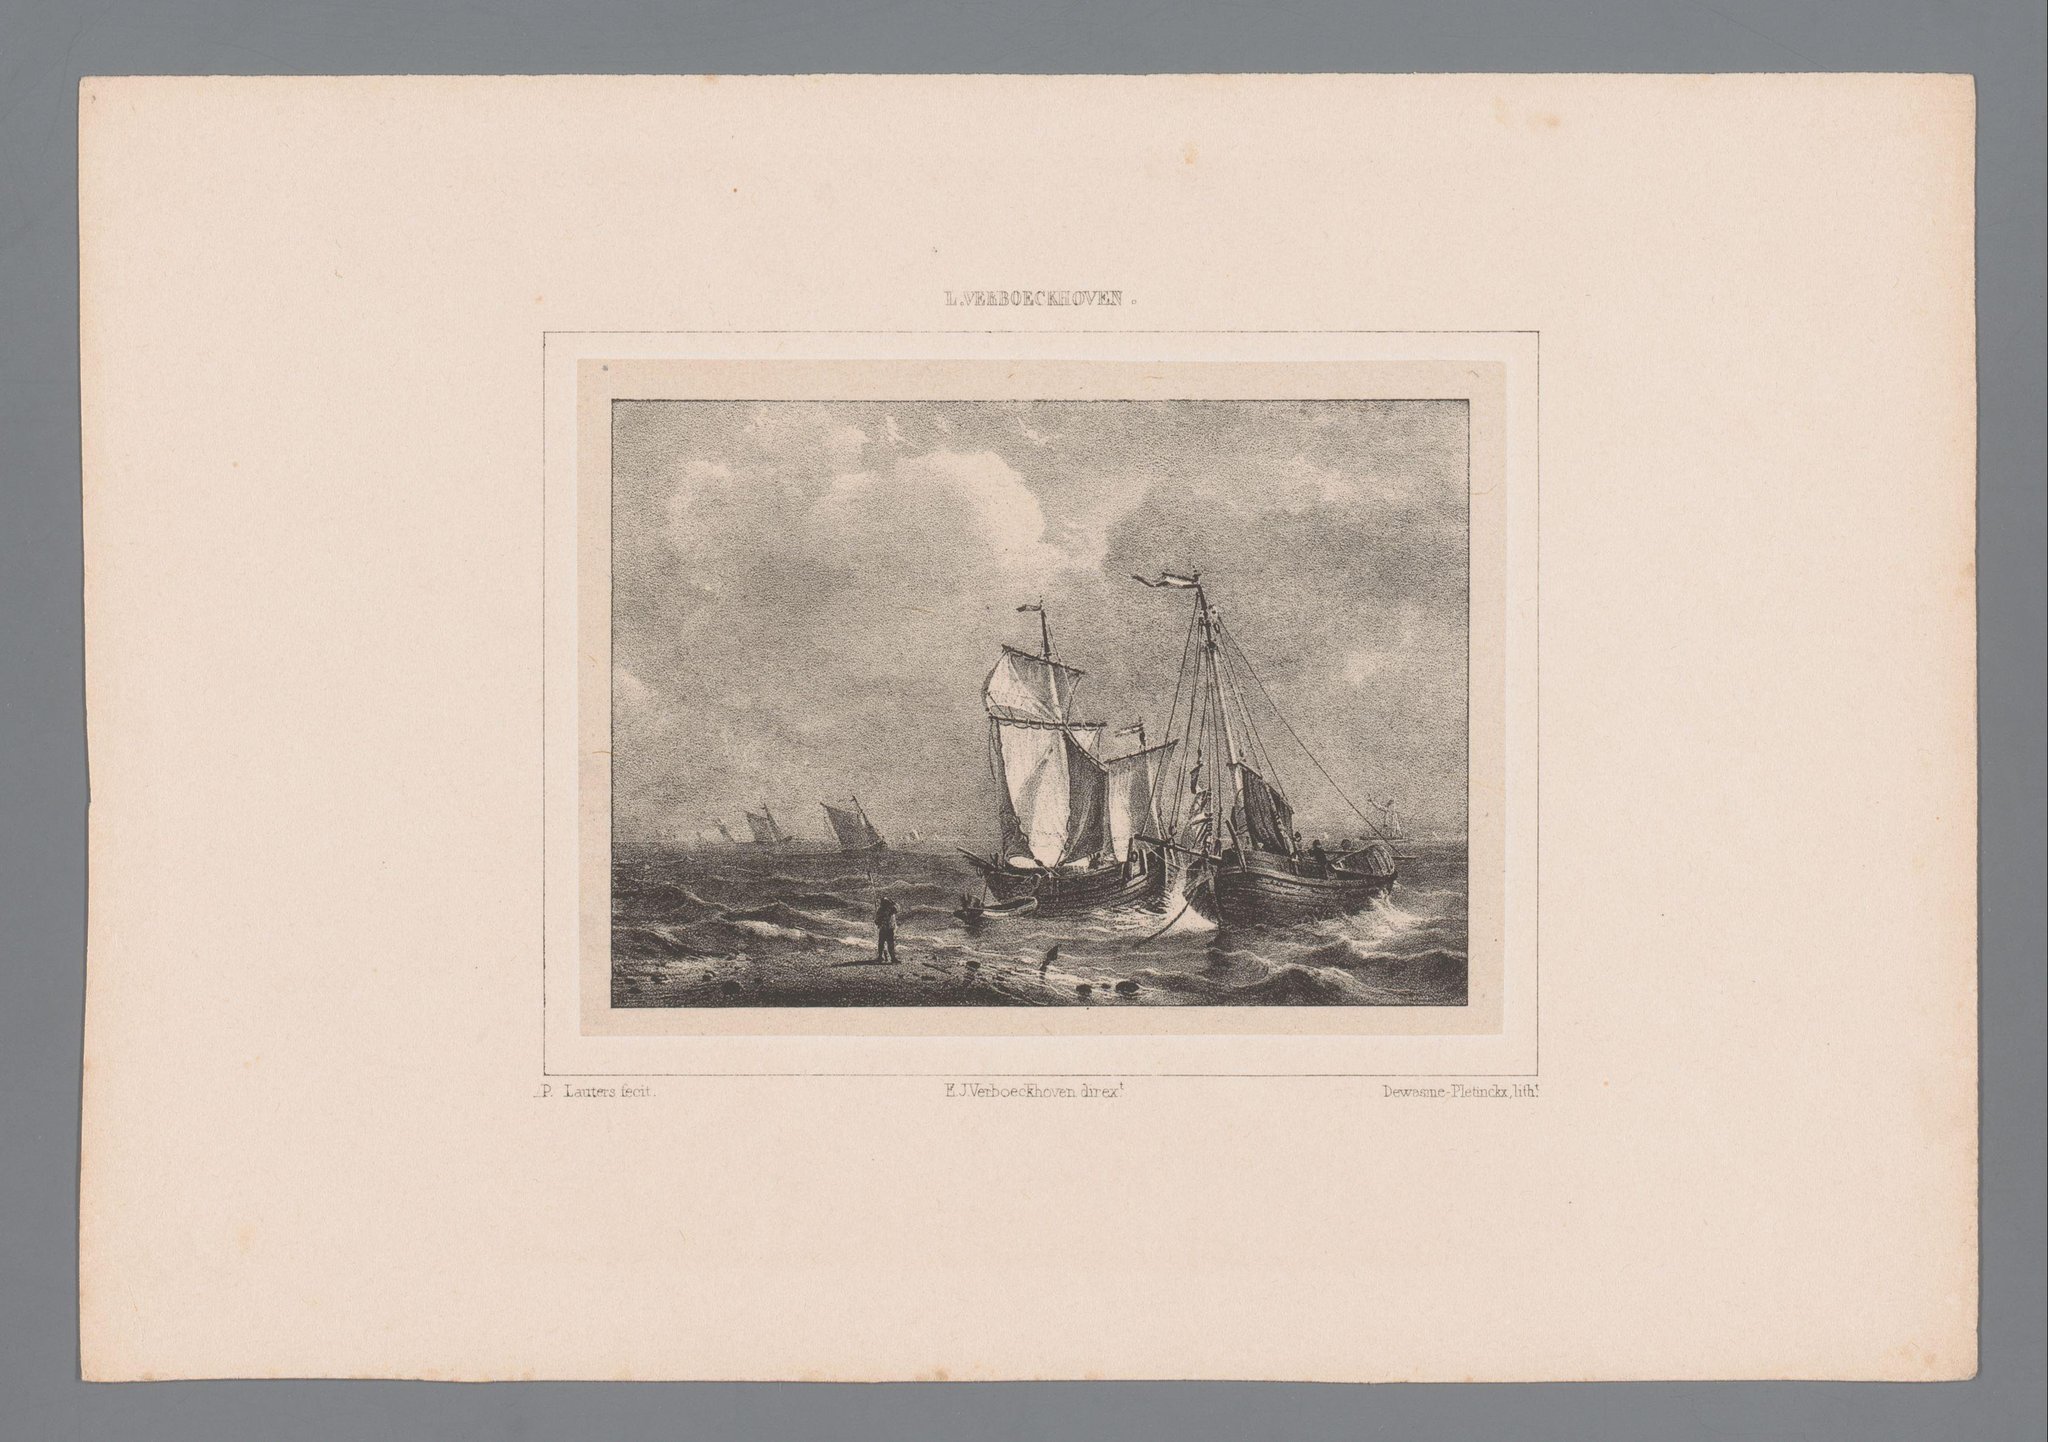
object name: print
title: Schepen aan de kust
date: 1829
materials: paper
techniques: lithograph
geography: brussels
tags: ships (in general) - cc - more than one ship, coast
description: Prent verschenen in: Verboeckhoven, Eugène. Album lithographié par Paul Lauters d'après les dessins des principaux peintres du Royaume des Pays-Bas. Brussel: Antoine Dewasme-Pletinckx, 1829.